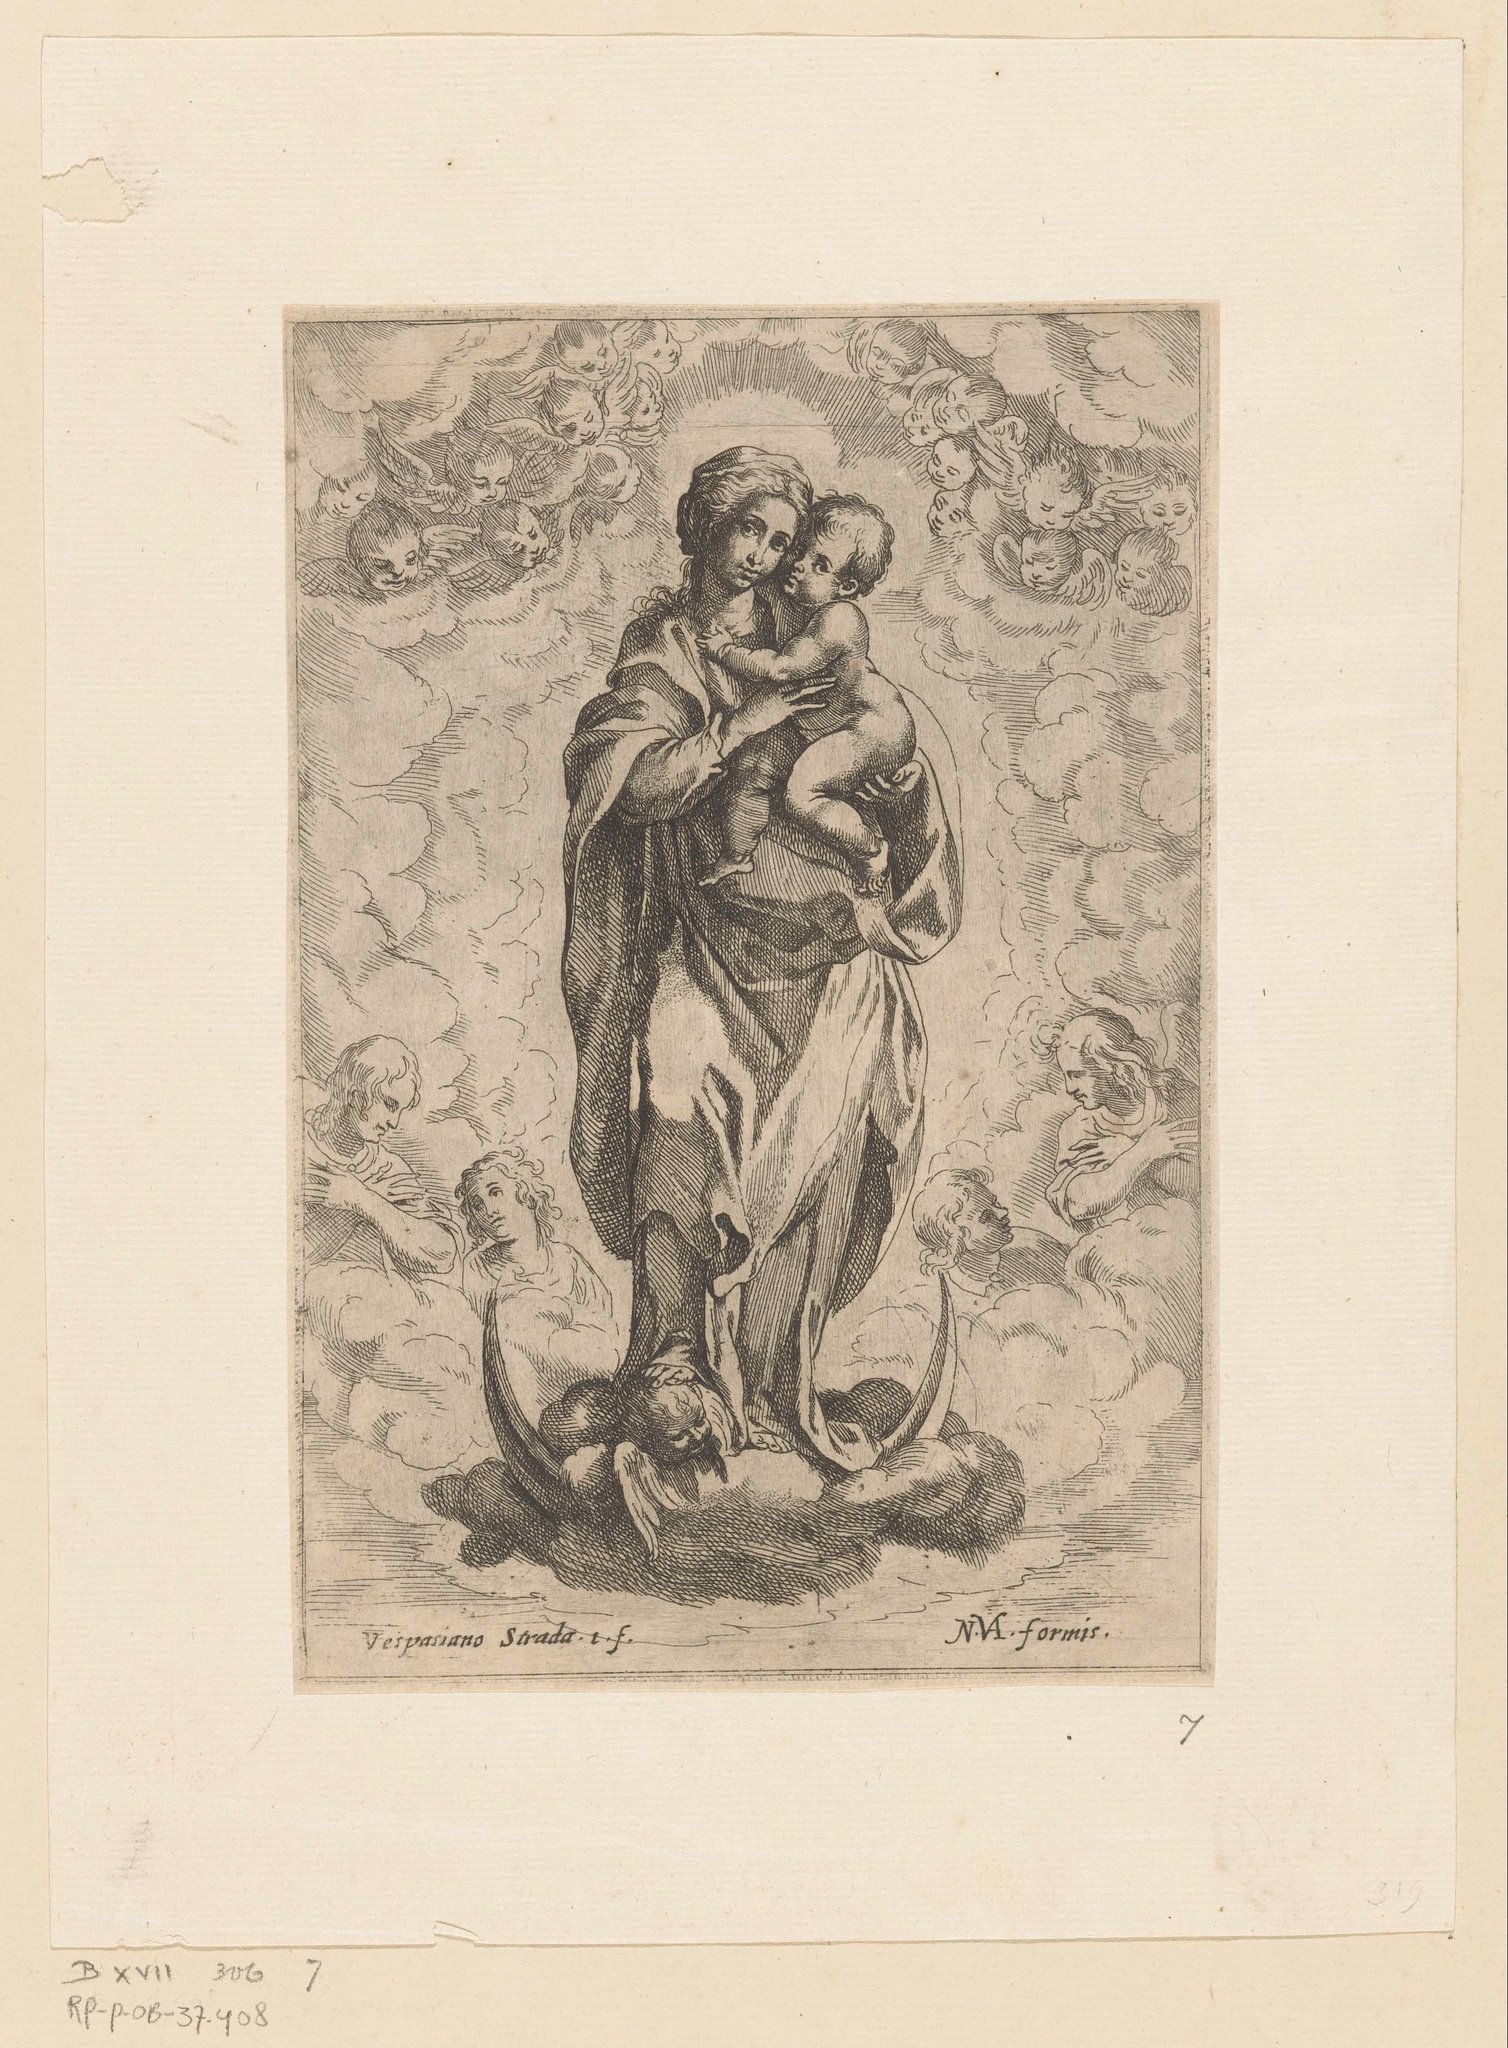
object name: print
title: Maria met Kind op maansikkel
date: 1592-1613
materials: paper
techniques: etching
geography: italy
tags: madonna on the crescent of the moon (sometimes called queen of heaven) (in mandorla)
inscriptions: collector's mark: Lugt 240